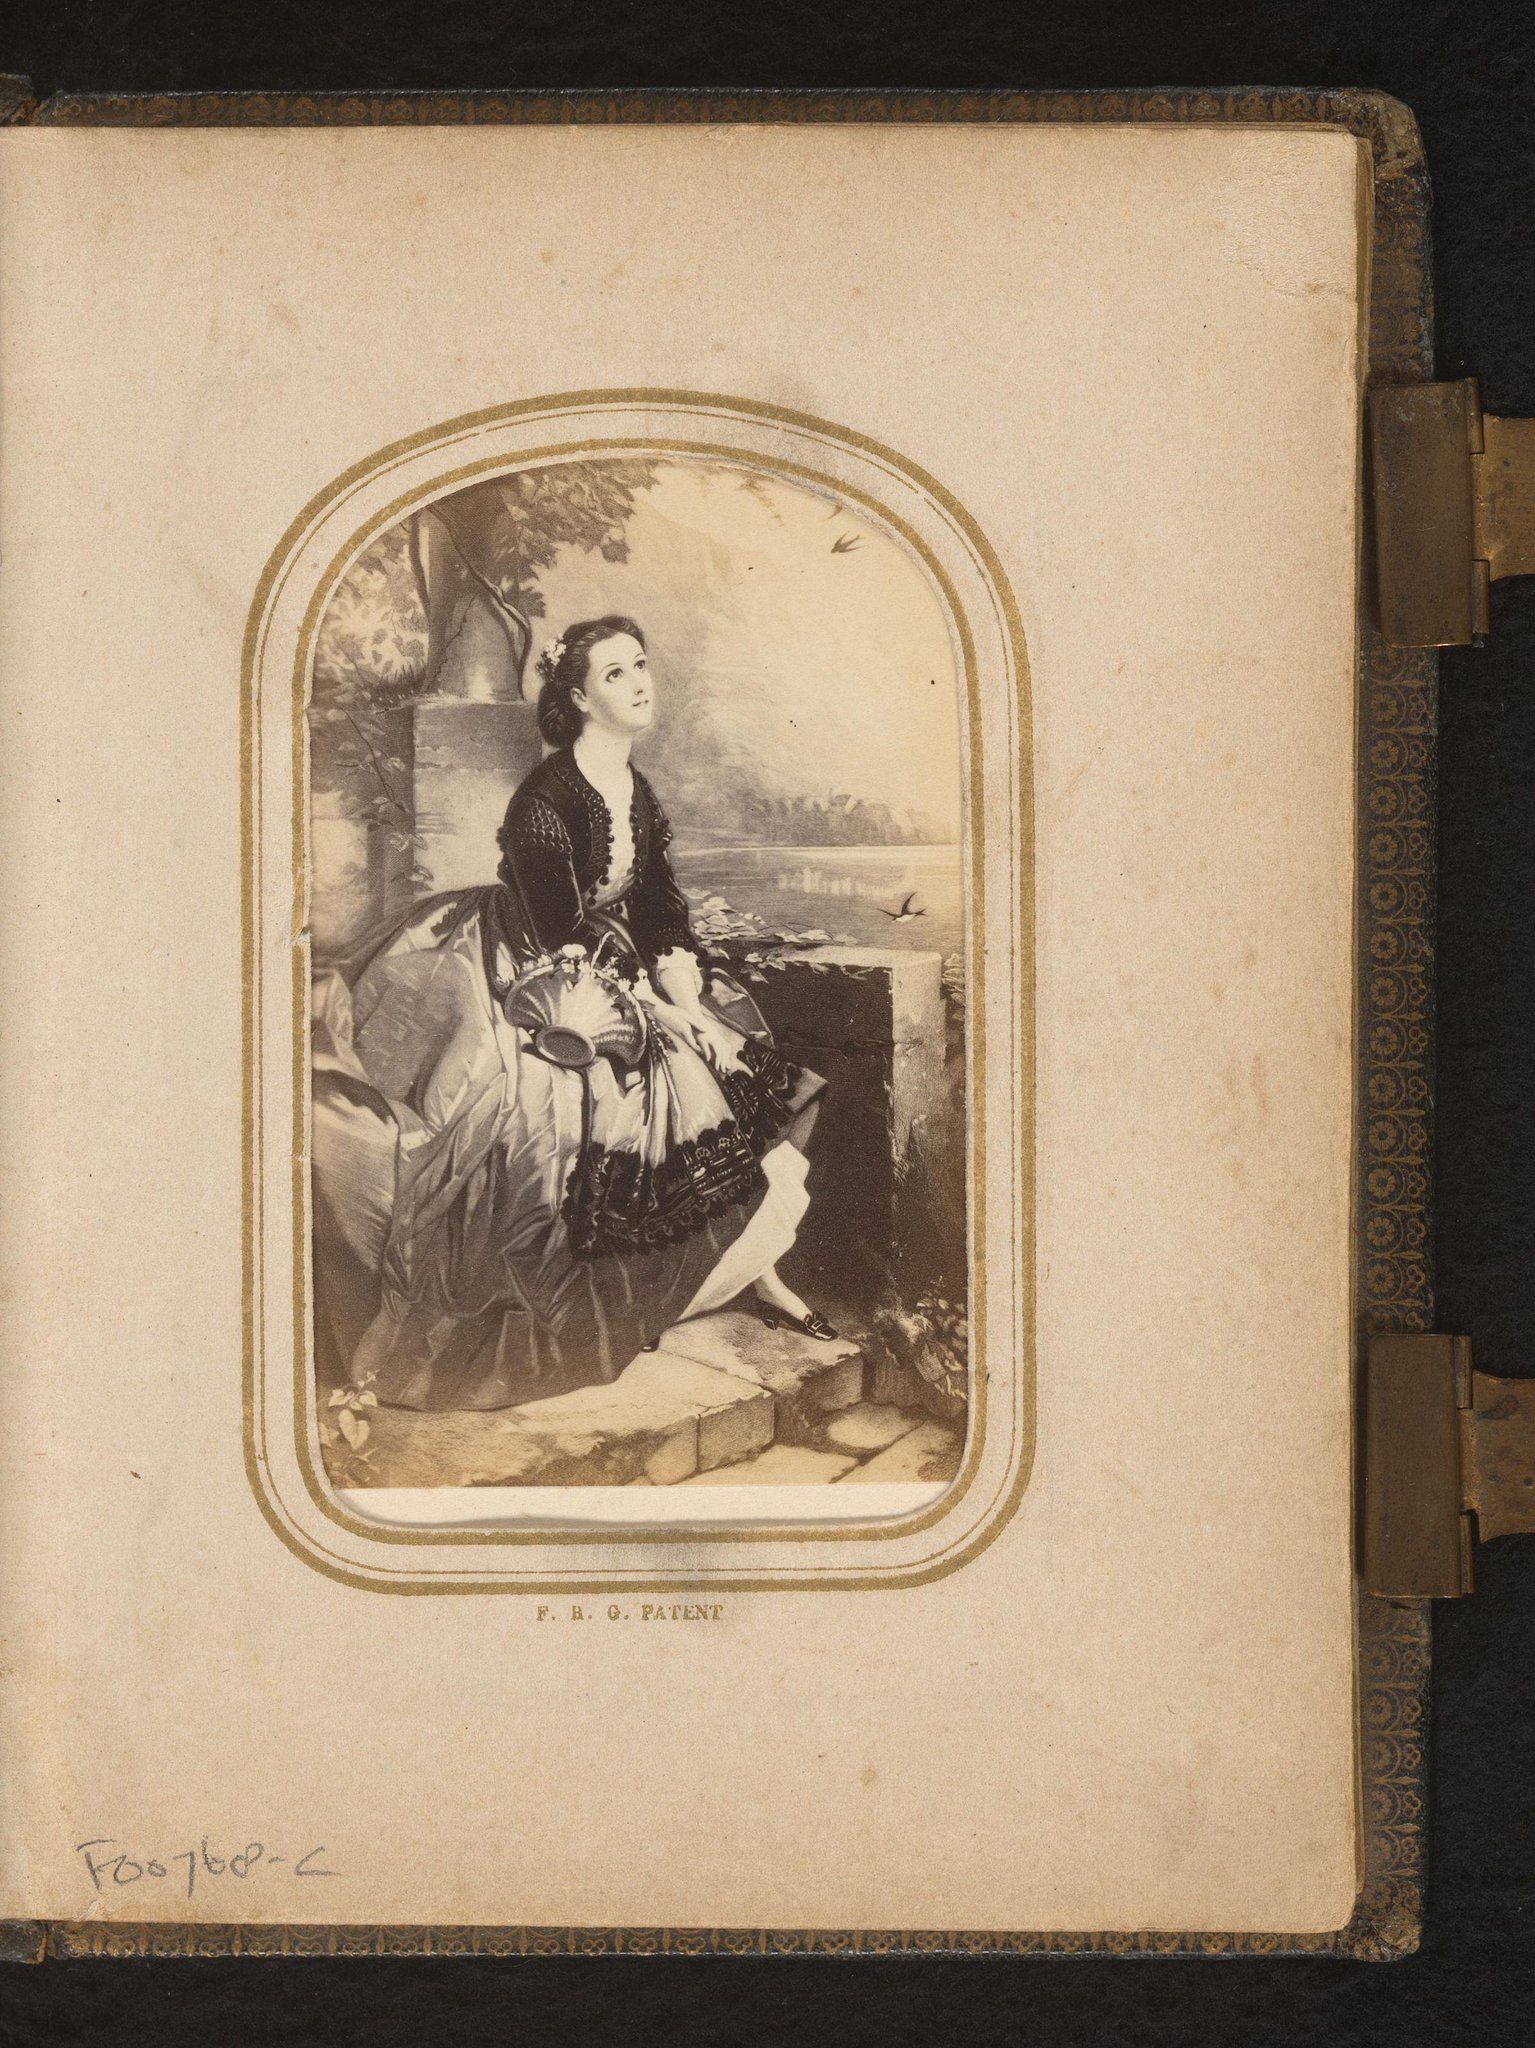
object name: reproduction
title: Fotoreproductie van een schilderij van een zittende vrouw met bloemenmandje aan een water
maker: Anonymous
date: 1865-1890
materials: cardboard, photographic support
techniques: albumen print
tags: adult woman, landscapes with waters, waterscapes, seascapes (in the temperate zone), painting, drawing and the graphic arts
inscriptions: number: ‘3772’